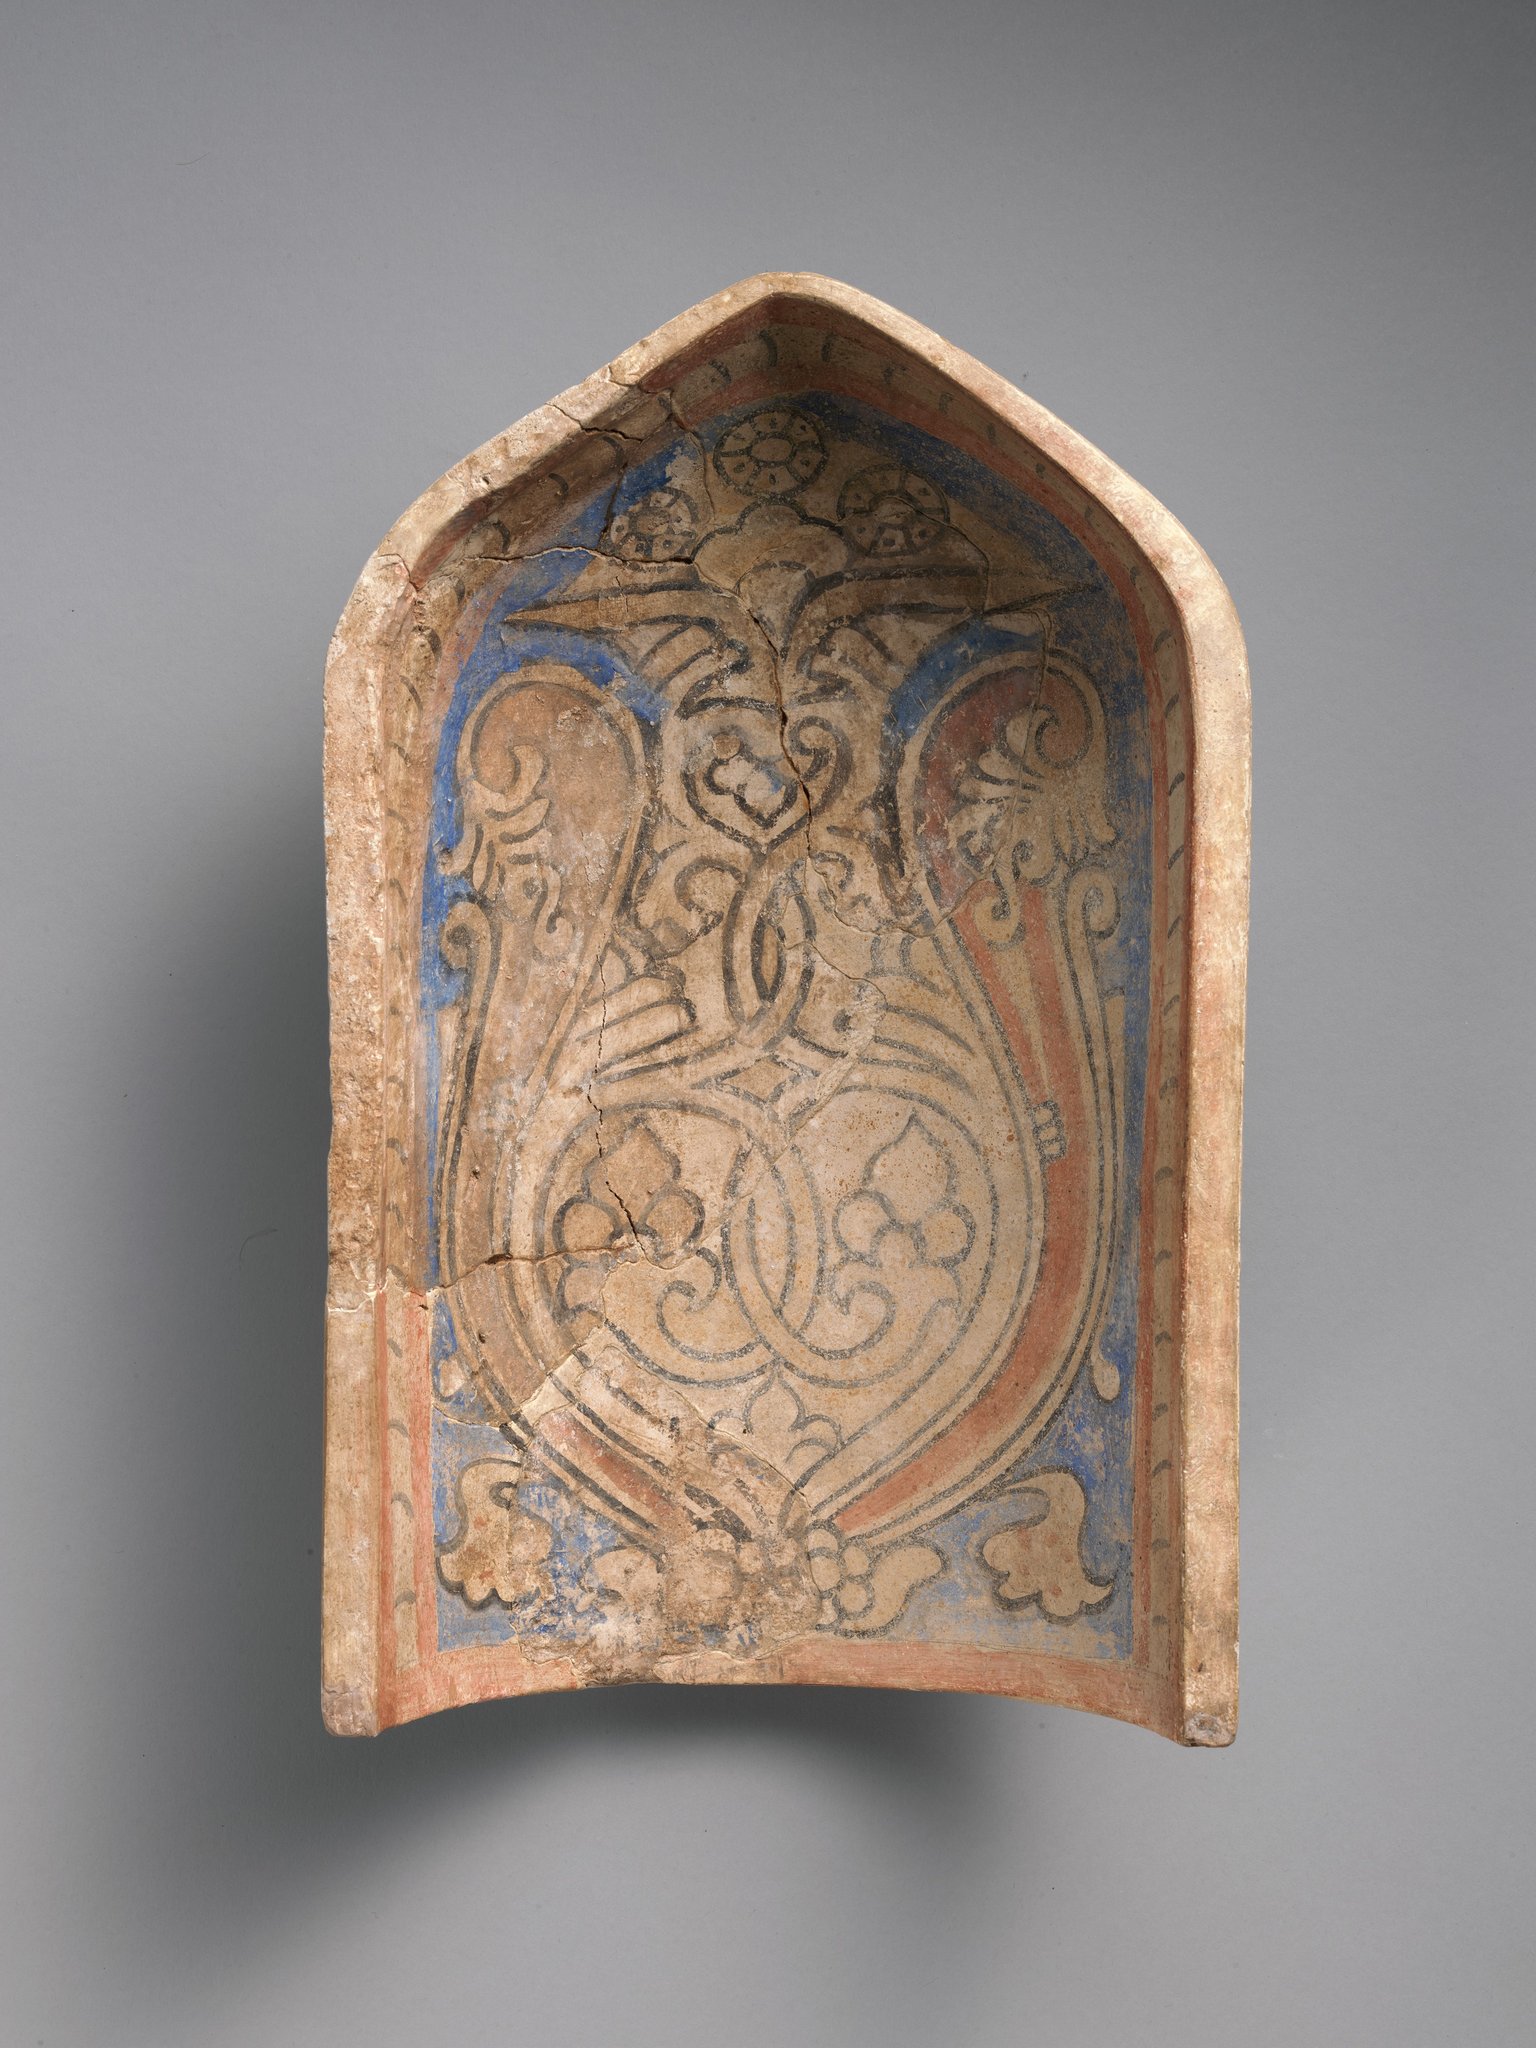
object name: squinch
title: Element from a Stalactite Squinch (Muqarnas)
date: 901-1000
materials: plaster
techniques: painting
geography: iran